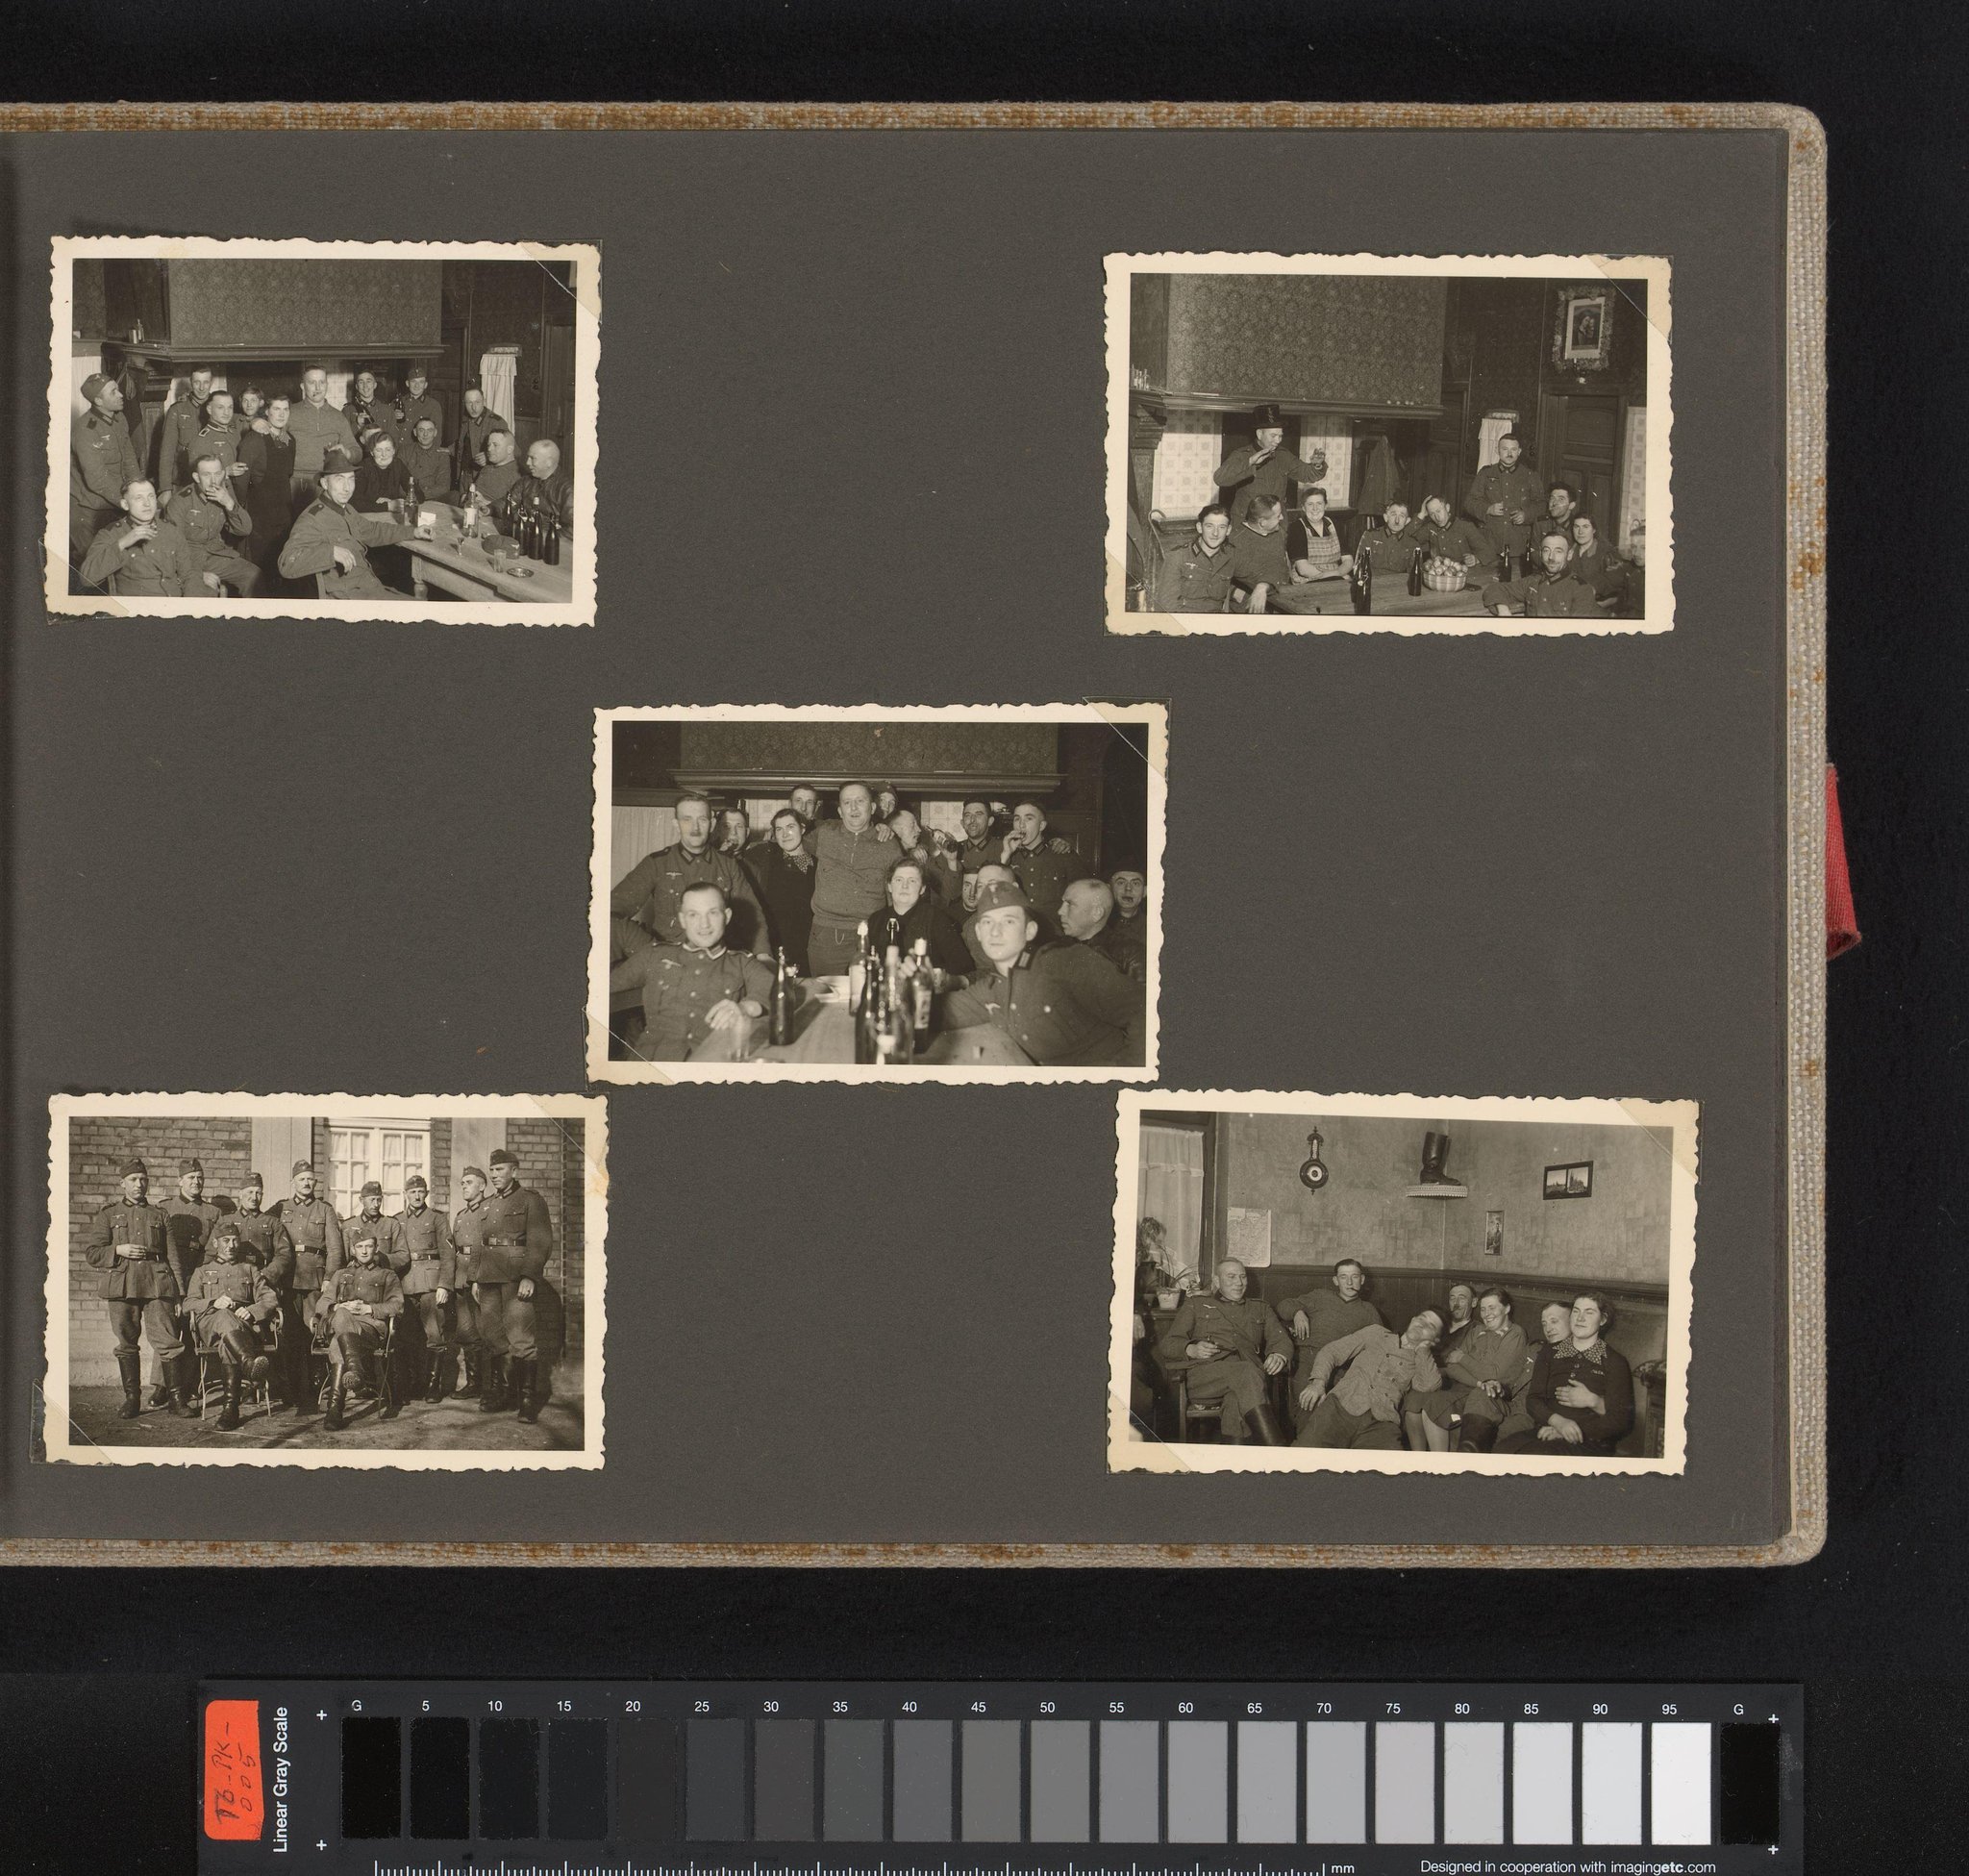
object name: album leaf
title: Feestavond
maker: Anonymous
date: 1911-1939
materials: cardboard, photographic support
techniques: gelatin silver print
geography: germany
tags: the company, the unit, the troop ~ military service, soldiers in gay company, military training, beer, ale, germany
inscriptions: inscription: ‘... XI 1939’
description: Albumblad met vijf foto's van een bijeenkomst van drinkende militairen en enkele vrouwen, november 1939. Onderdeel van de fotoalbum van de Wehrmacht 1938-1941.